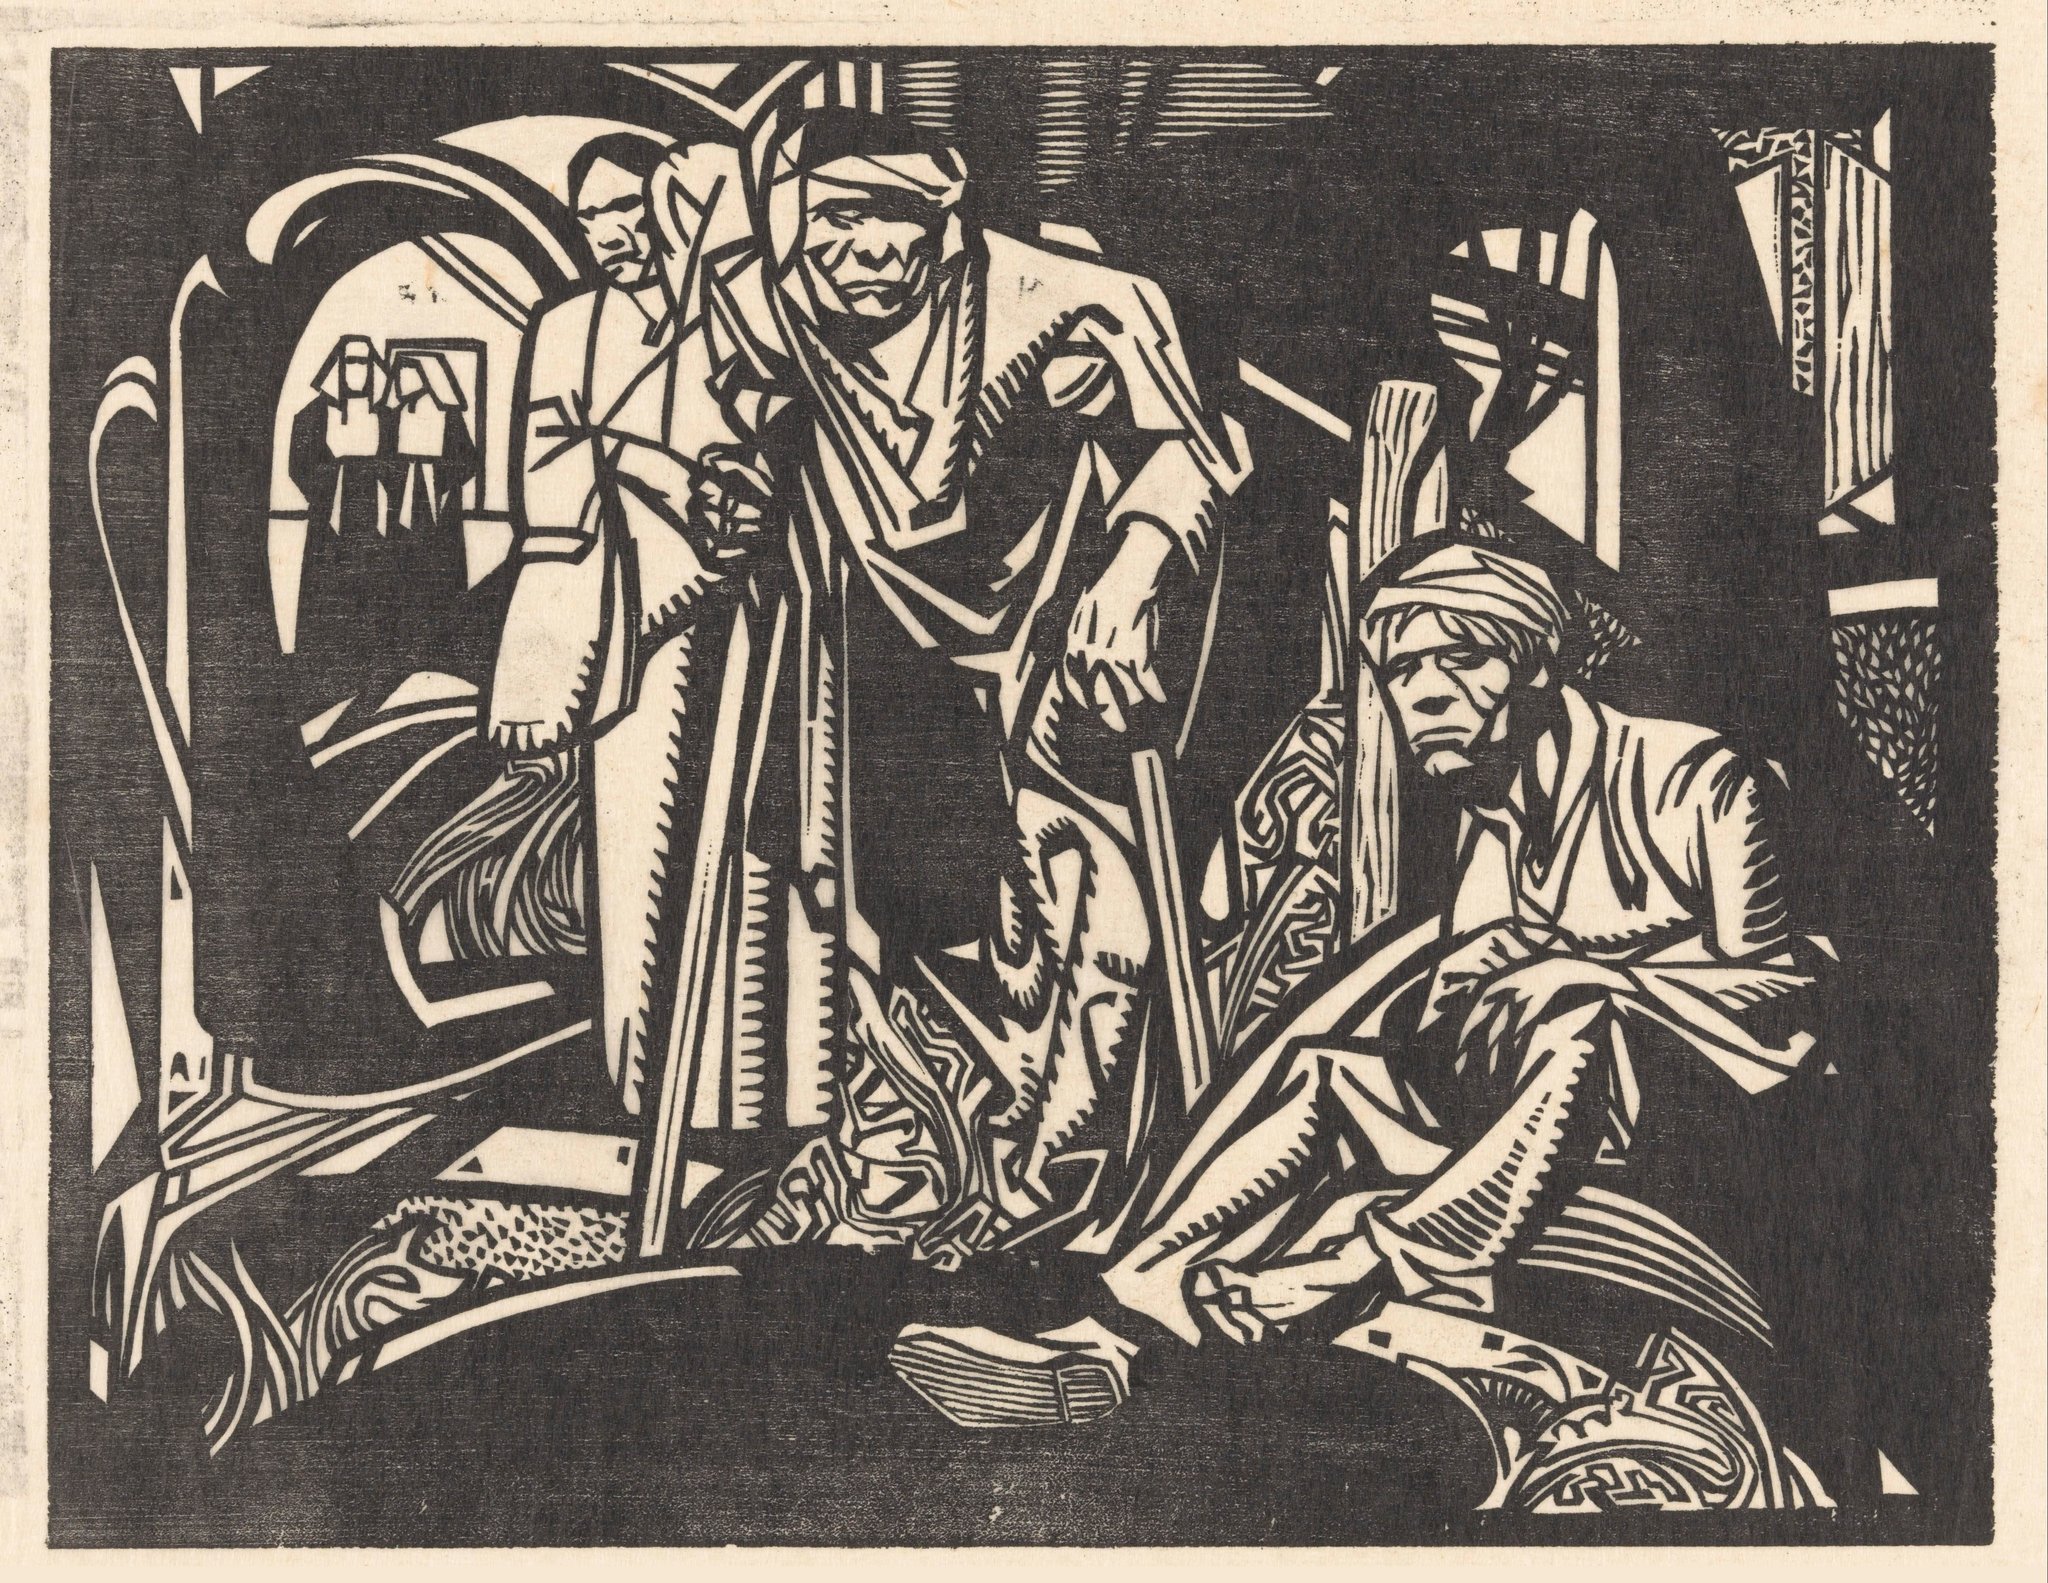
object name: print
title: Gewonden in een kerk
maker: johannes josephus aarts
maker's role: draughtsman, print maker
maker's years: 1871-1934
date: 1881-1934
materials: paper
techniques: woodcut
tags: crutches, nun(s), patient, sick person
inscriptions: collector's mark: Lugt 2228, collector's mark: Lugt 2760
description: Een man leunt op twee krukken. Rechts van hem zit een man met opgetrokken rechterbeen. Links op de achtergrond twee nonnen in habijt.